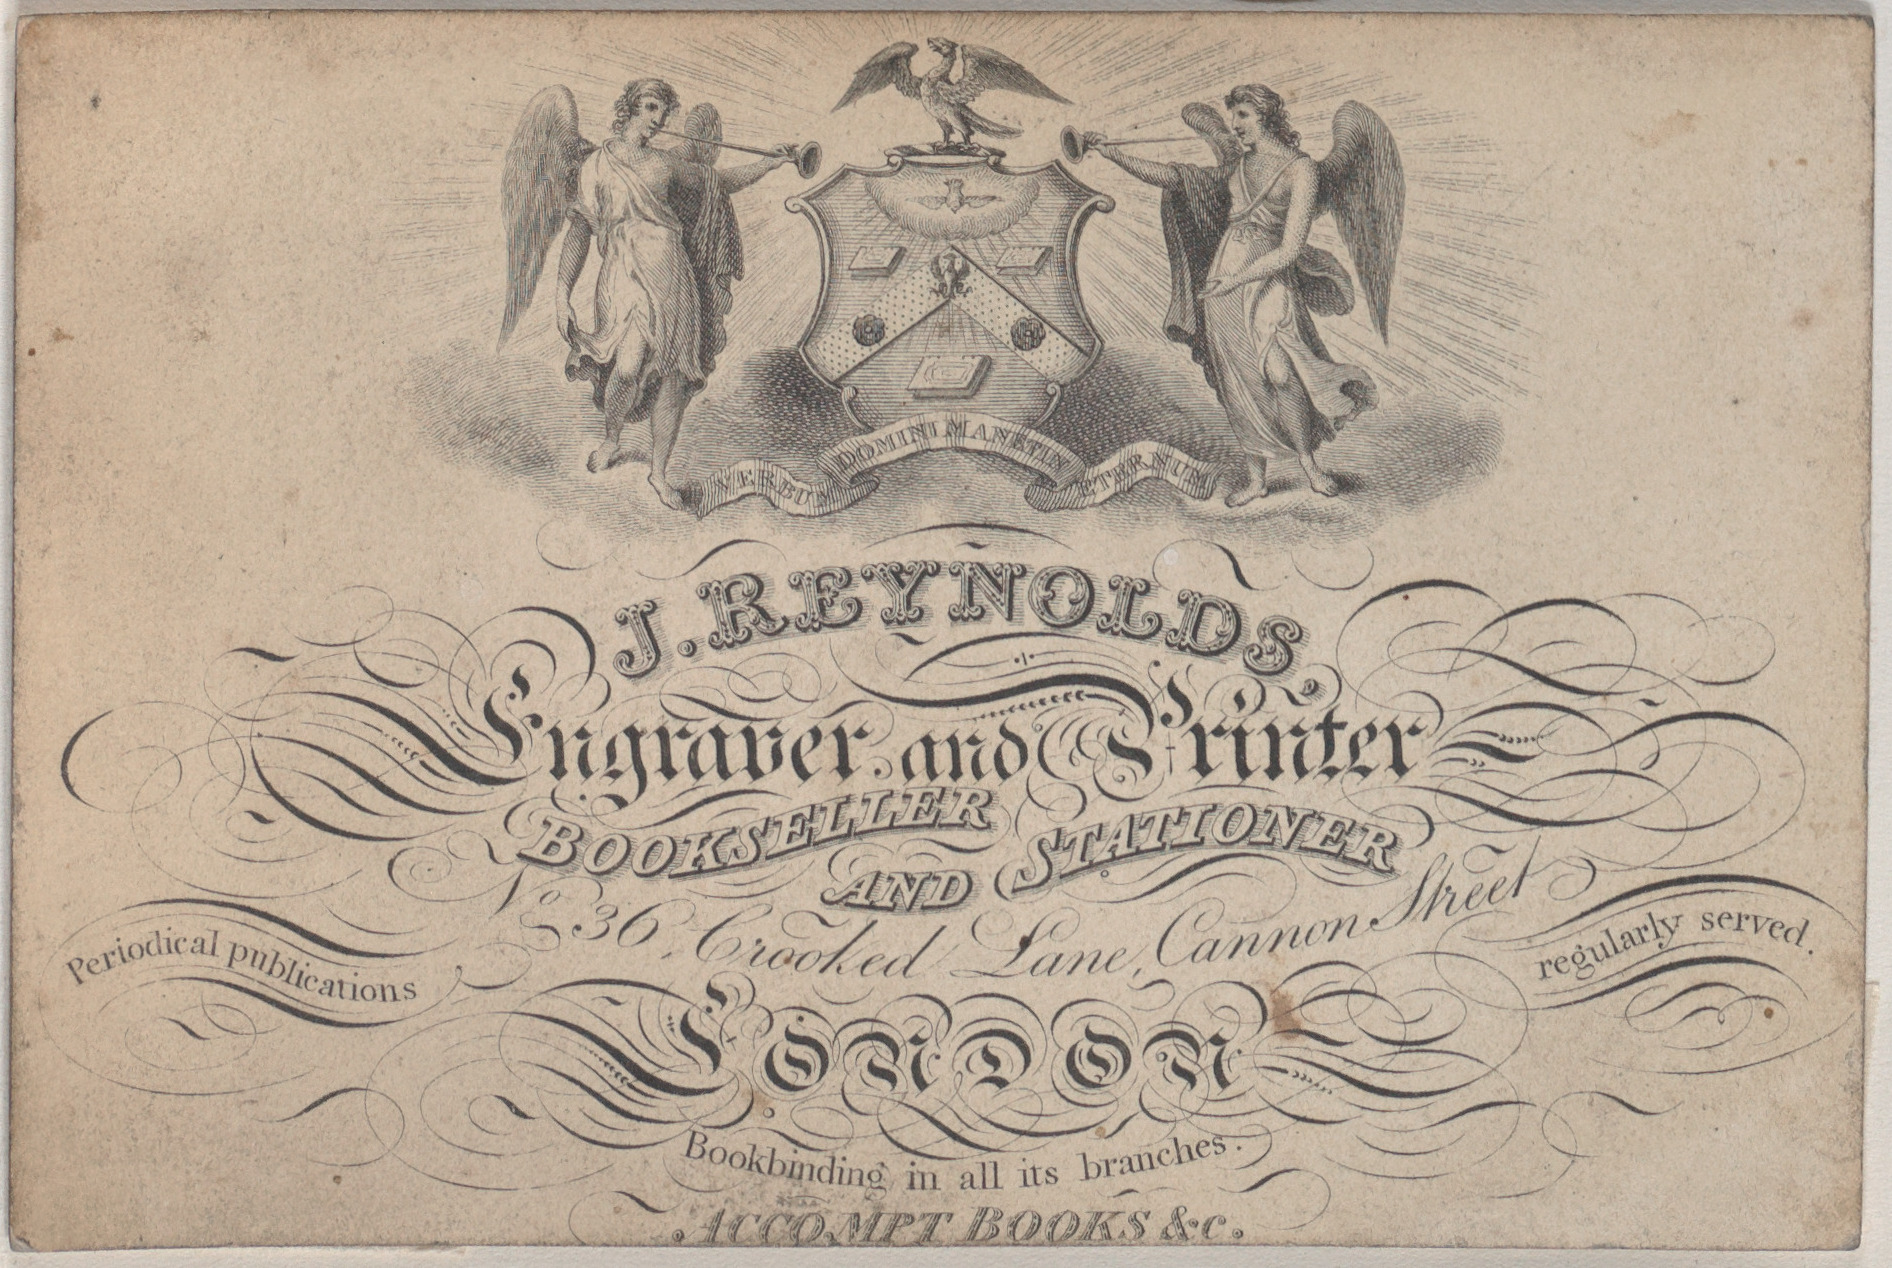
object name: print, trade card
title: Trade Card for J. Reynolds, Engraver, Printer, Bookseller, and Stationer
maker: anonymous, british, 19th century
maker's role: artist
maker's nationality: british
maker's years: 1800-1900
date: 1801-1900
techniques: engraving